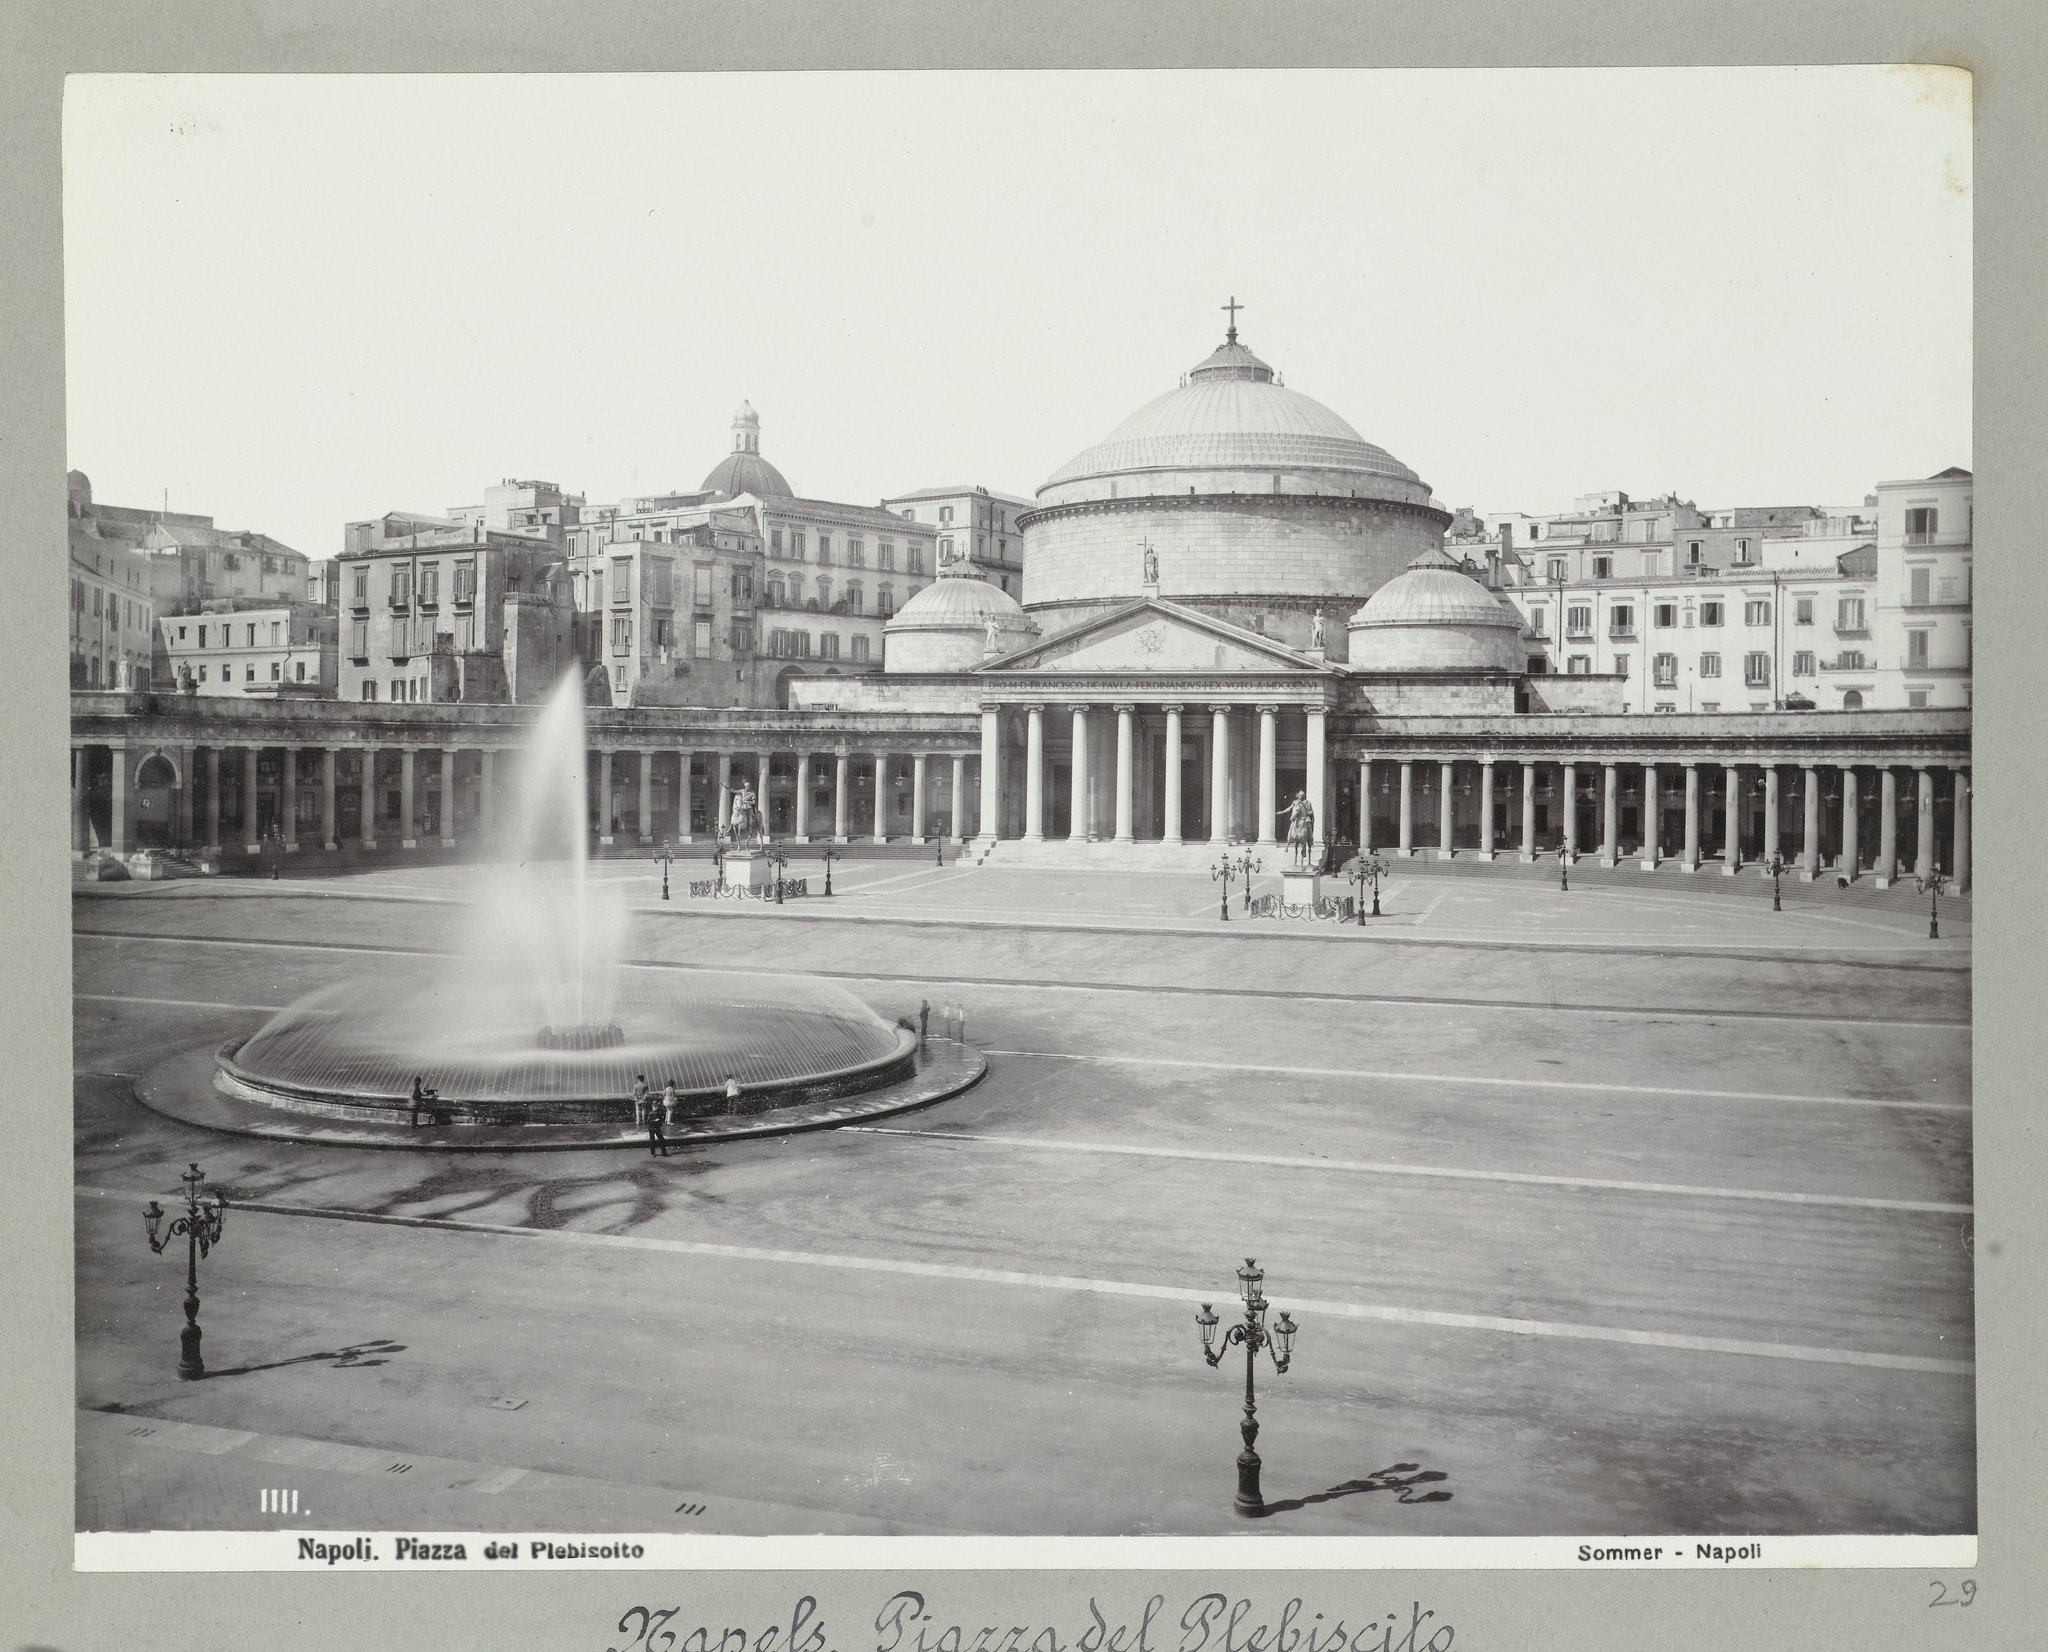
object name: photograph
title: Napels, piazza del Plebiscito.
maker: giorgio sommer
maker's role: fotograaf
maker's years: 1834-1914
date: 1893-1903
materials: cardboard, photographic support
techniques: albumen print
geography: naples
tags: naples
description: Het piazza del Plebiscito met op de achtergrond de kerk San Francesco di Paolo.